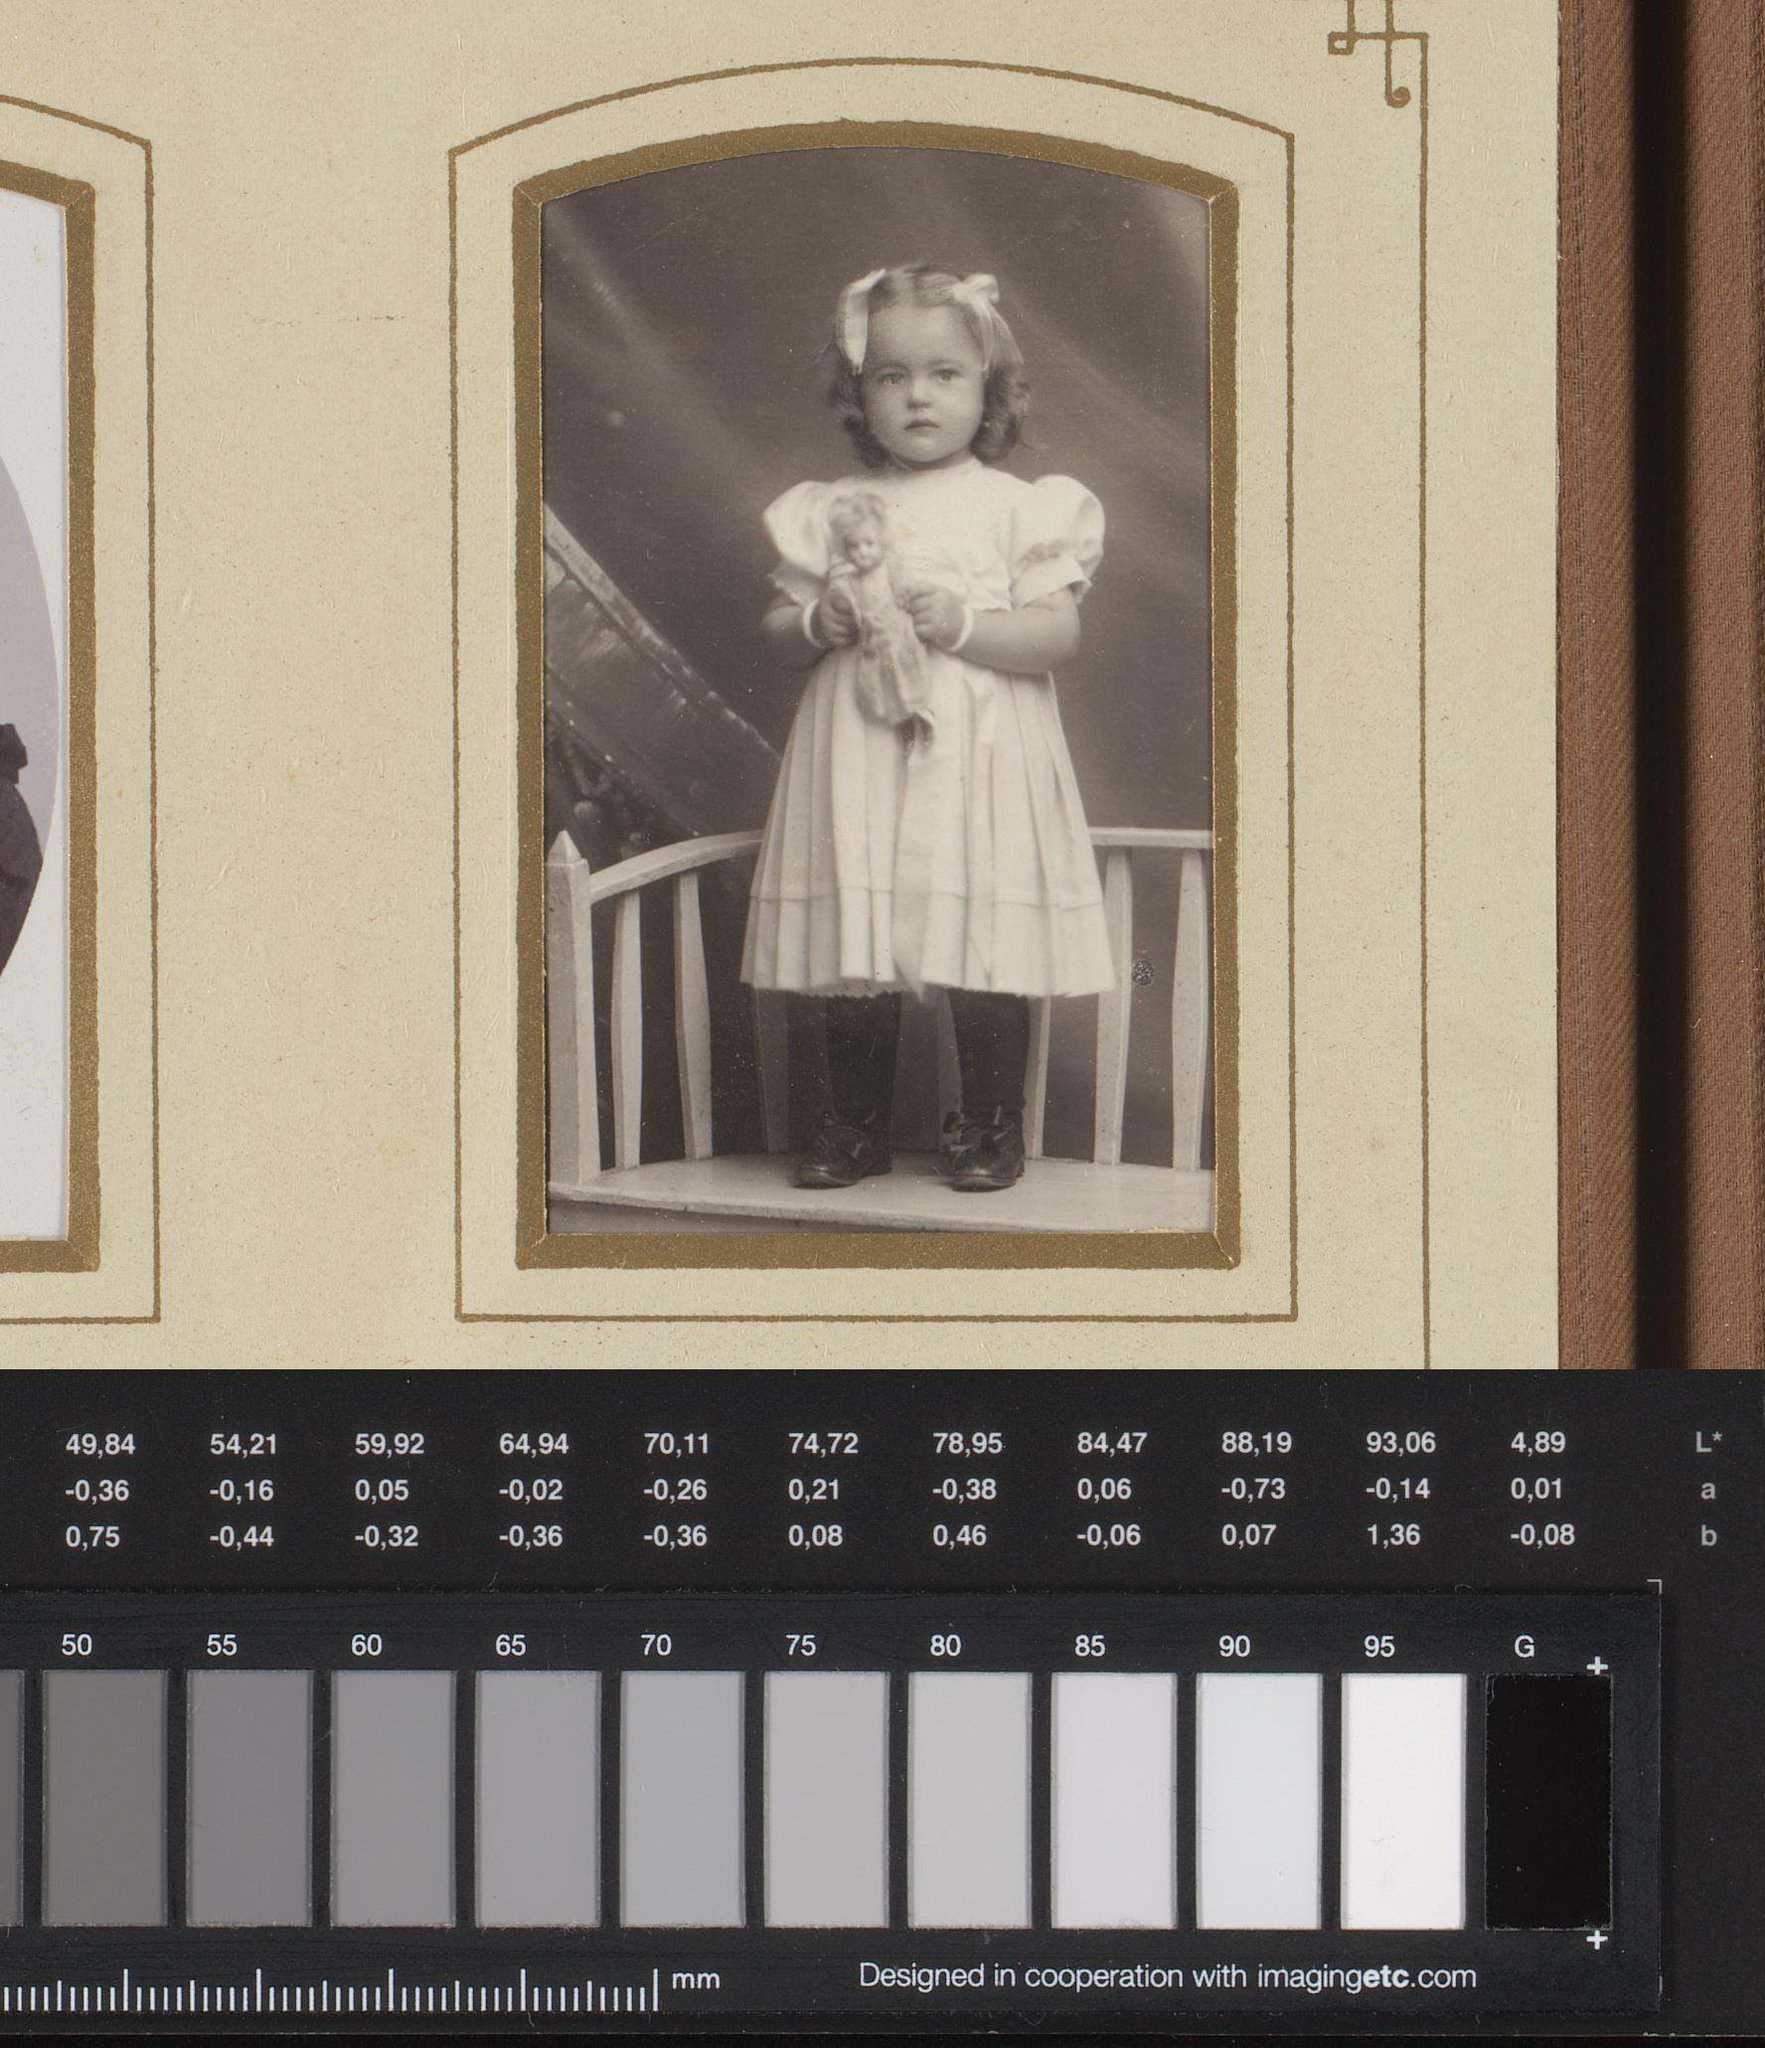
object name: carte de visite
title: Portret van een meisje met pop in de hand, staand op een houten bank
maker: willem hooijer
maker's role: fotograaf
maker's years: 1855-1939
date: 1903-1909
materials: cardboard, photographic support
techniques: collodion silver print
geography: alkmaar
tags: historical persons - bb - woman, (playing with) dolls, toddler (female)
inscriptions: inscription: ‘W. Hooijer/ Alkmaar/ Oudegracht 205.’